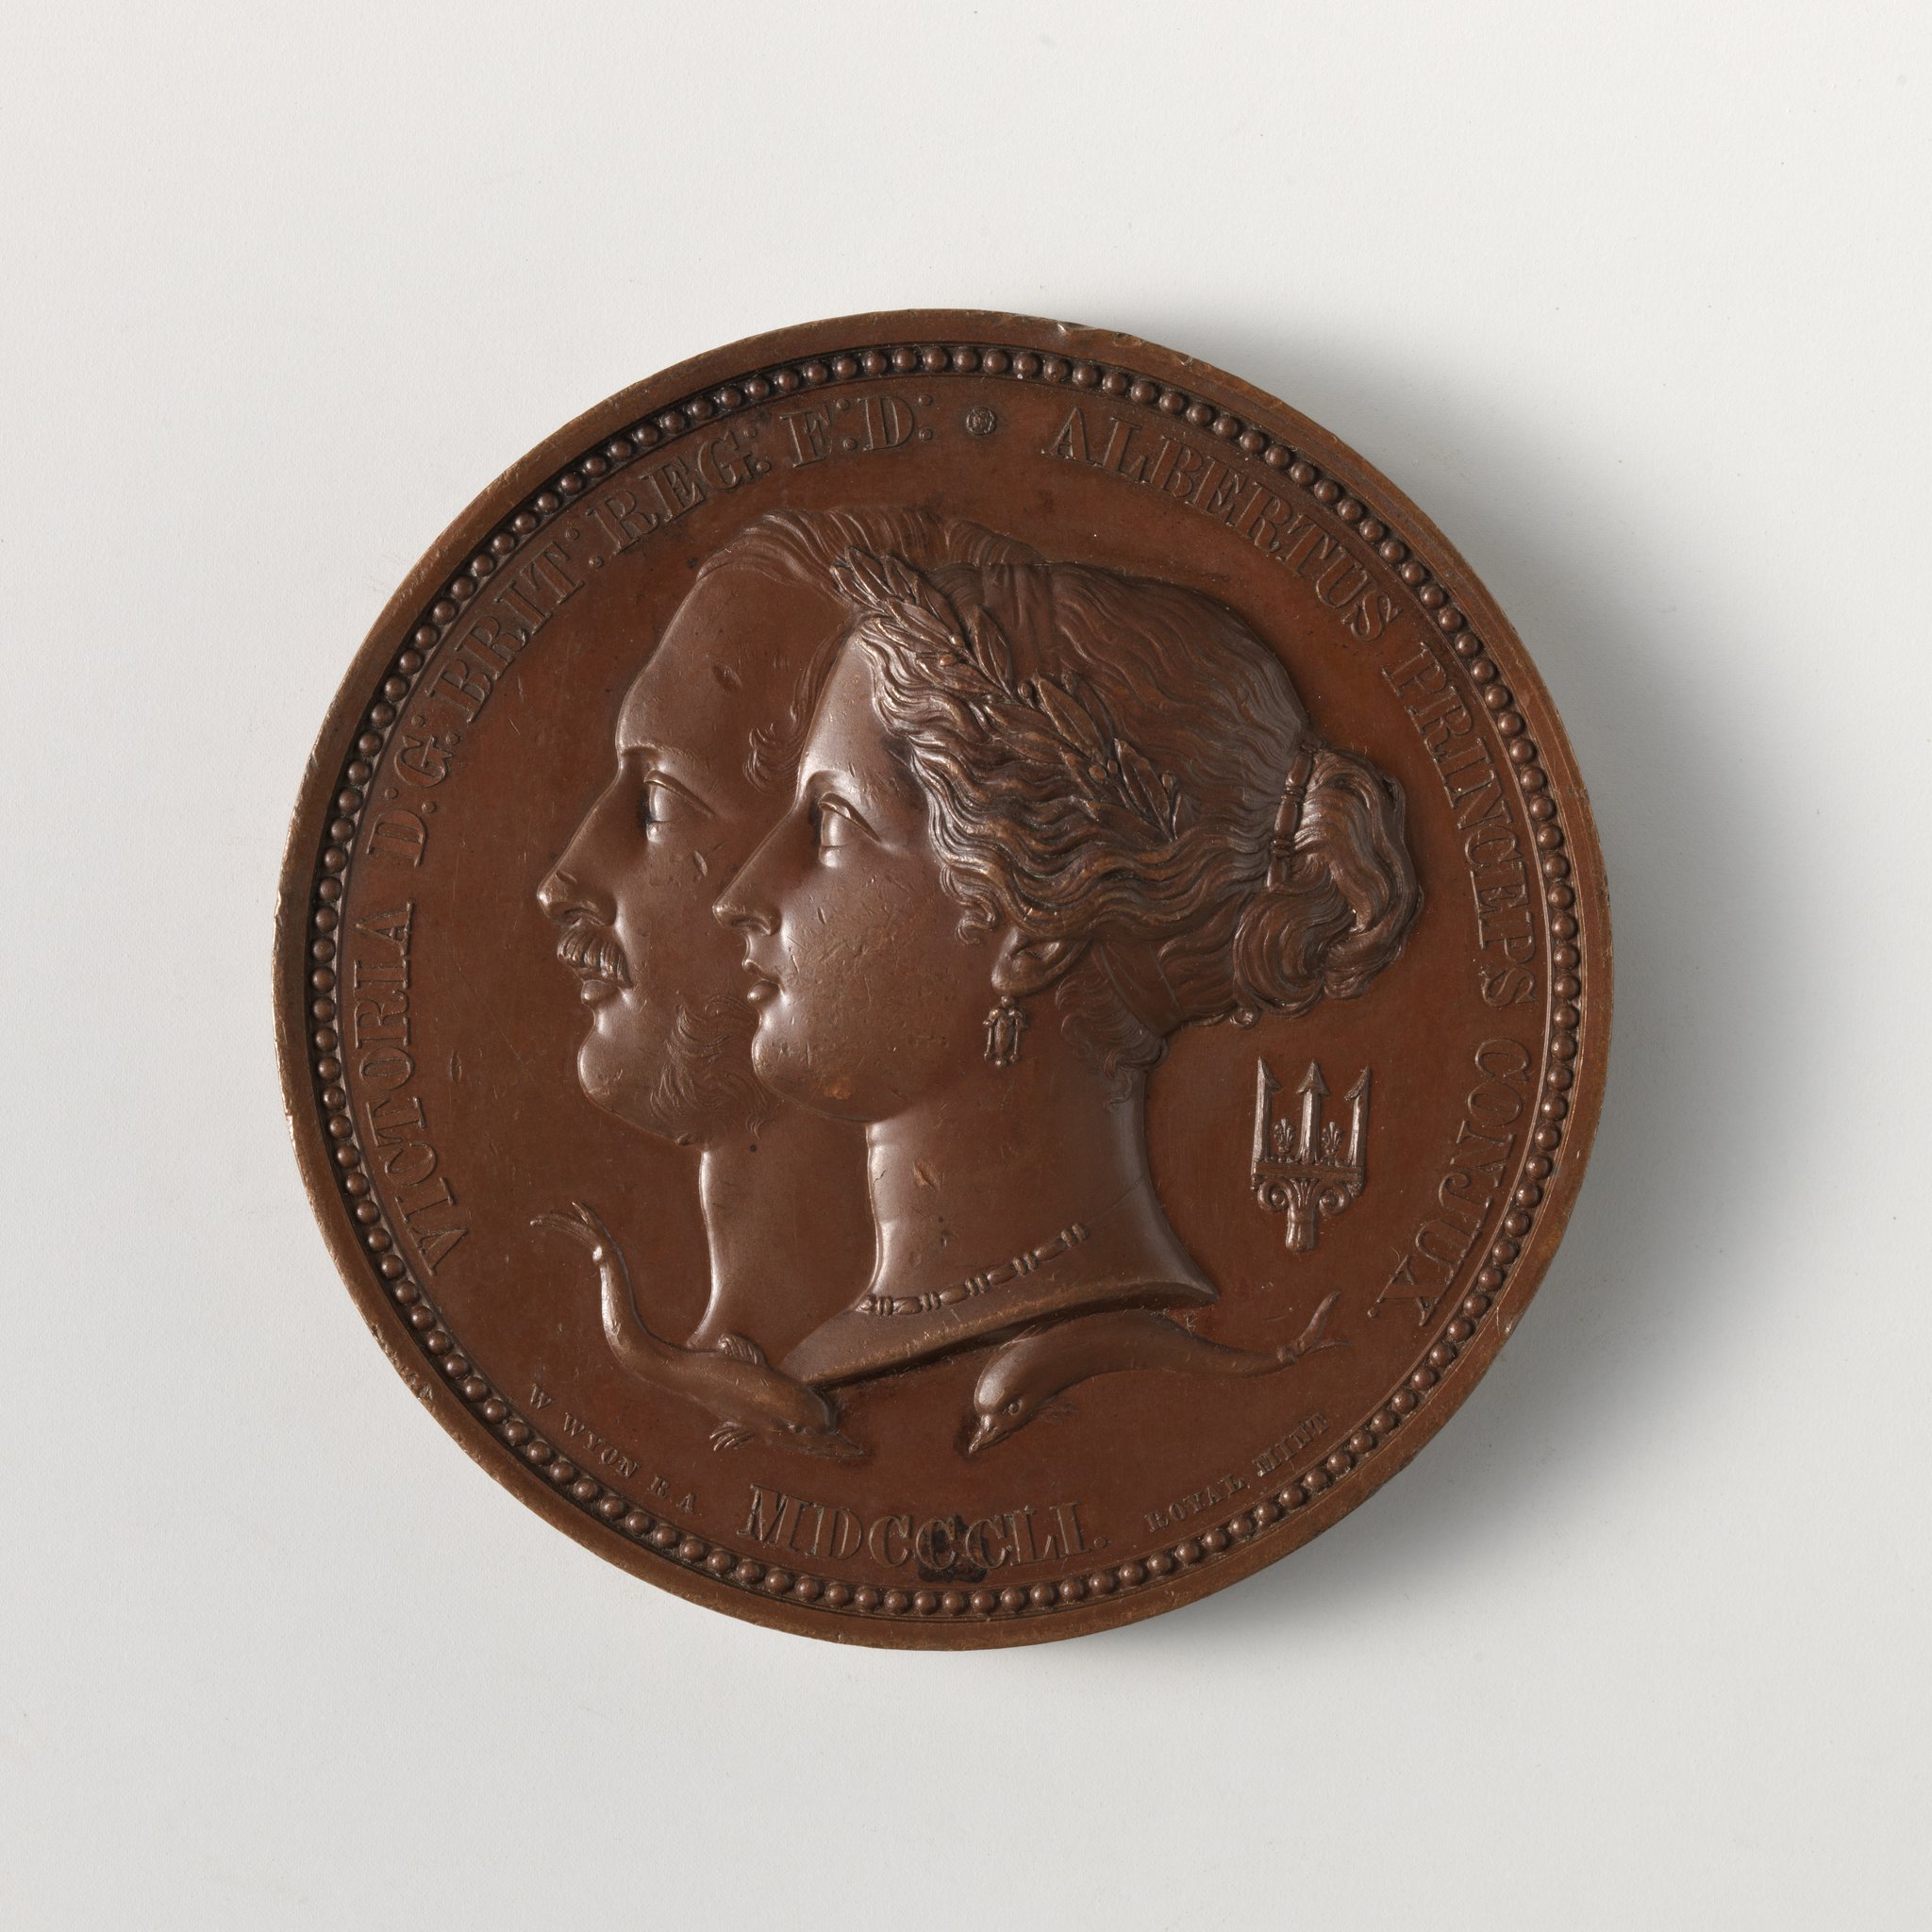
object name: medal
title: Great Exhibition Jurors' Medal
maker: william wyon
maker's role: artist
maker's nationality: british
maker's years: 1795-1851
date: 1851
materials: bronze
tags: men,profiles,women,queen victoria